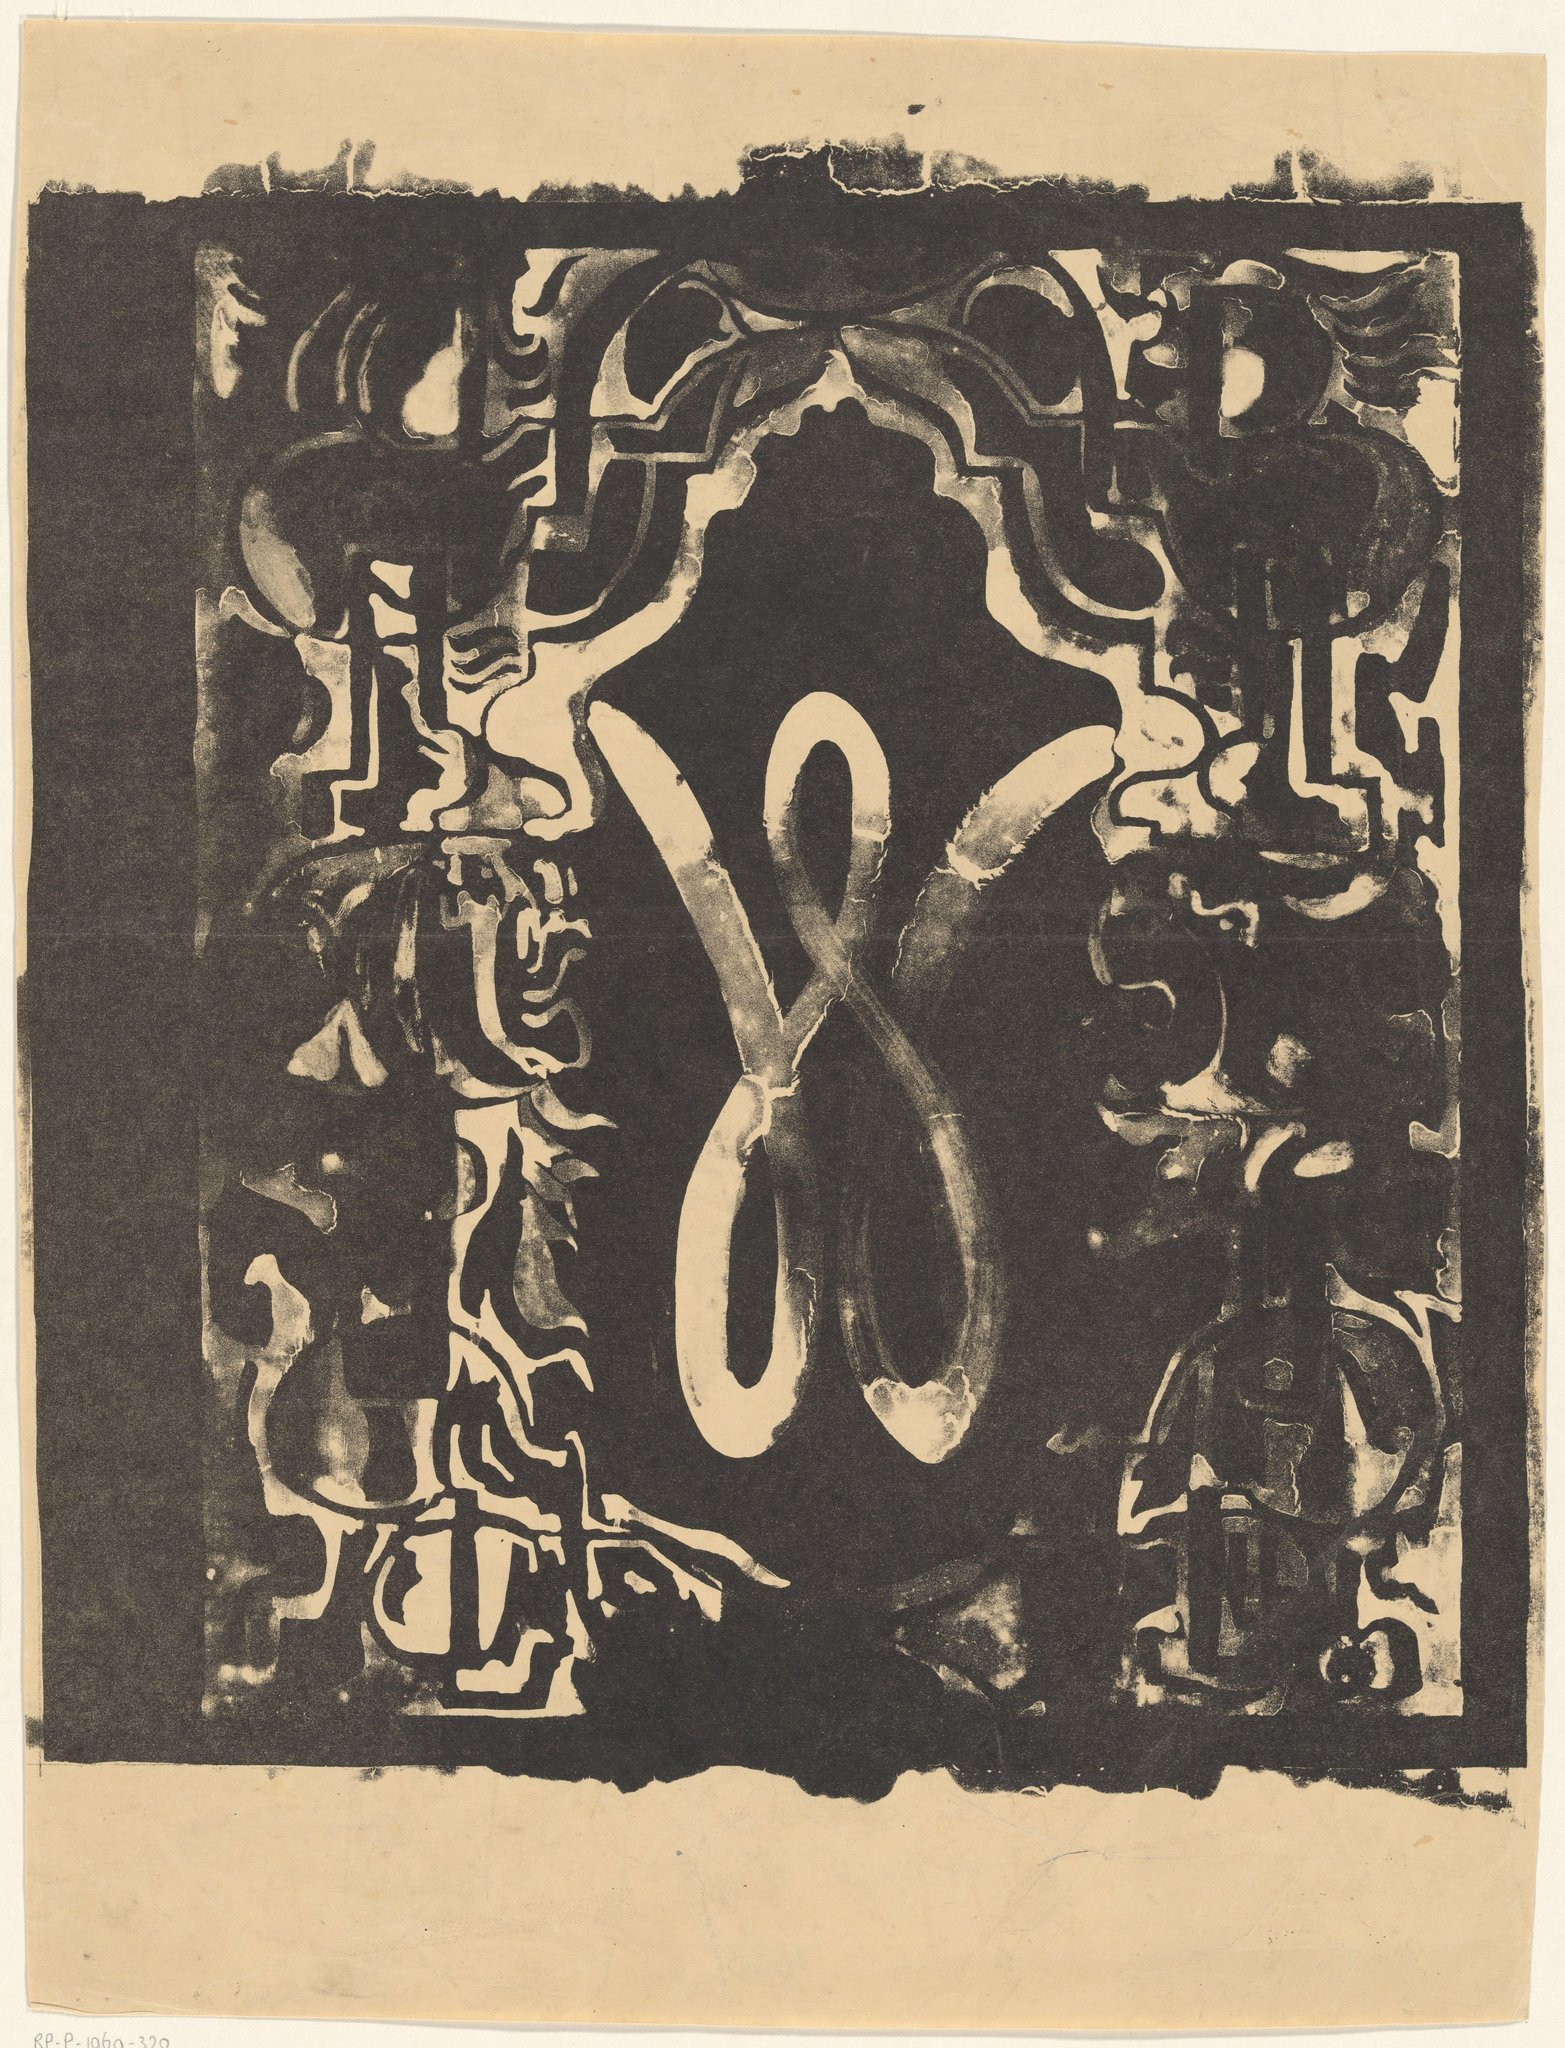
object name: wrapper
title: Omslagontwerp voor: Wendingen, augustus 1918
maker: carel adolph lion cachet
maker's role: draughtsman, print maker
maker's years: 1864-1945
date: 1918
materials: paper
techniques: lithograph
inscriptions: collector's mark: Lugt 2228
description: Prent mogelijk gebruikt voor: Wendingen. Maandblad voor bouwen en sieren van "Architectura et Amicitia". Amsterdam: De Hooge Brug 1918, 1/8.